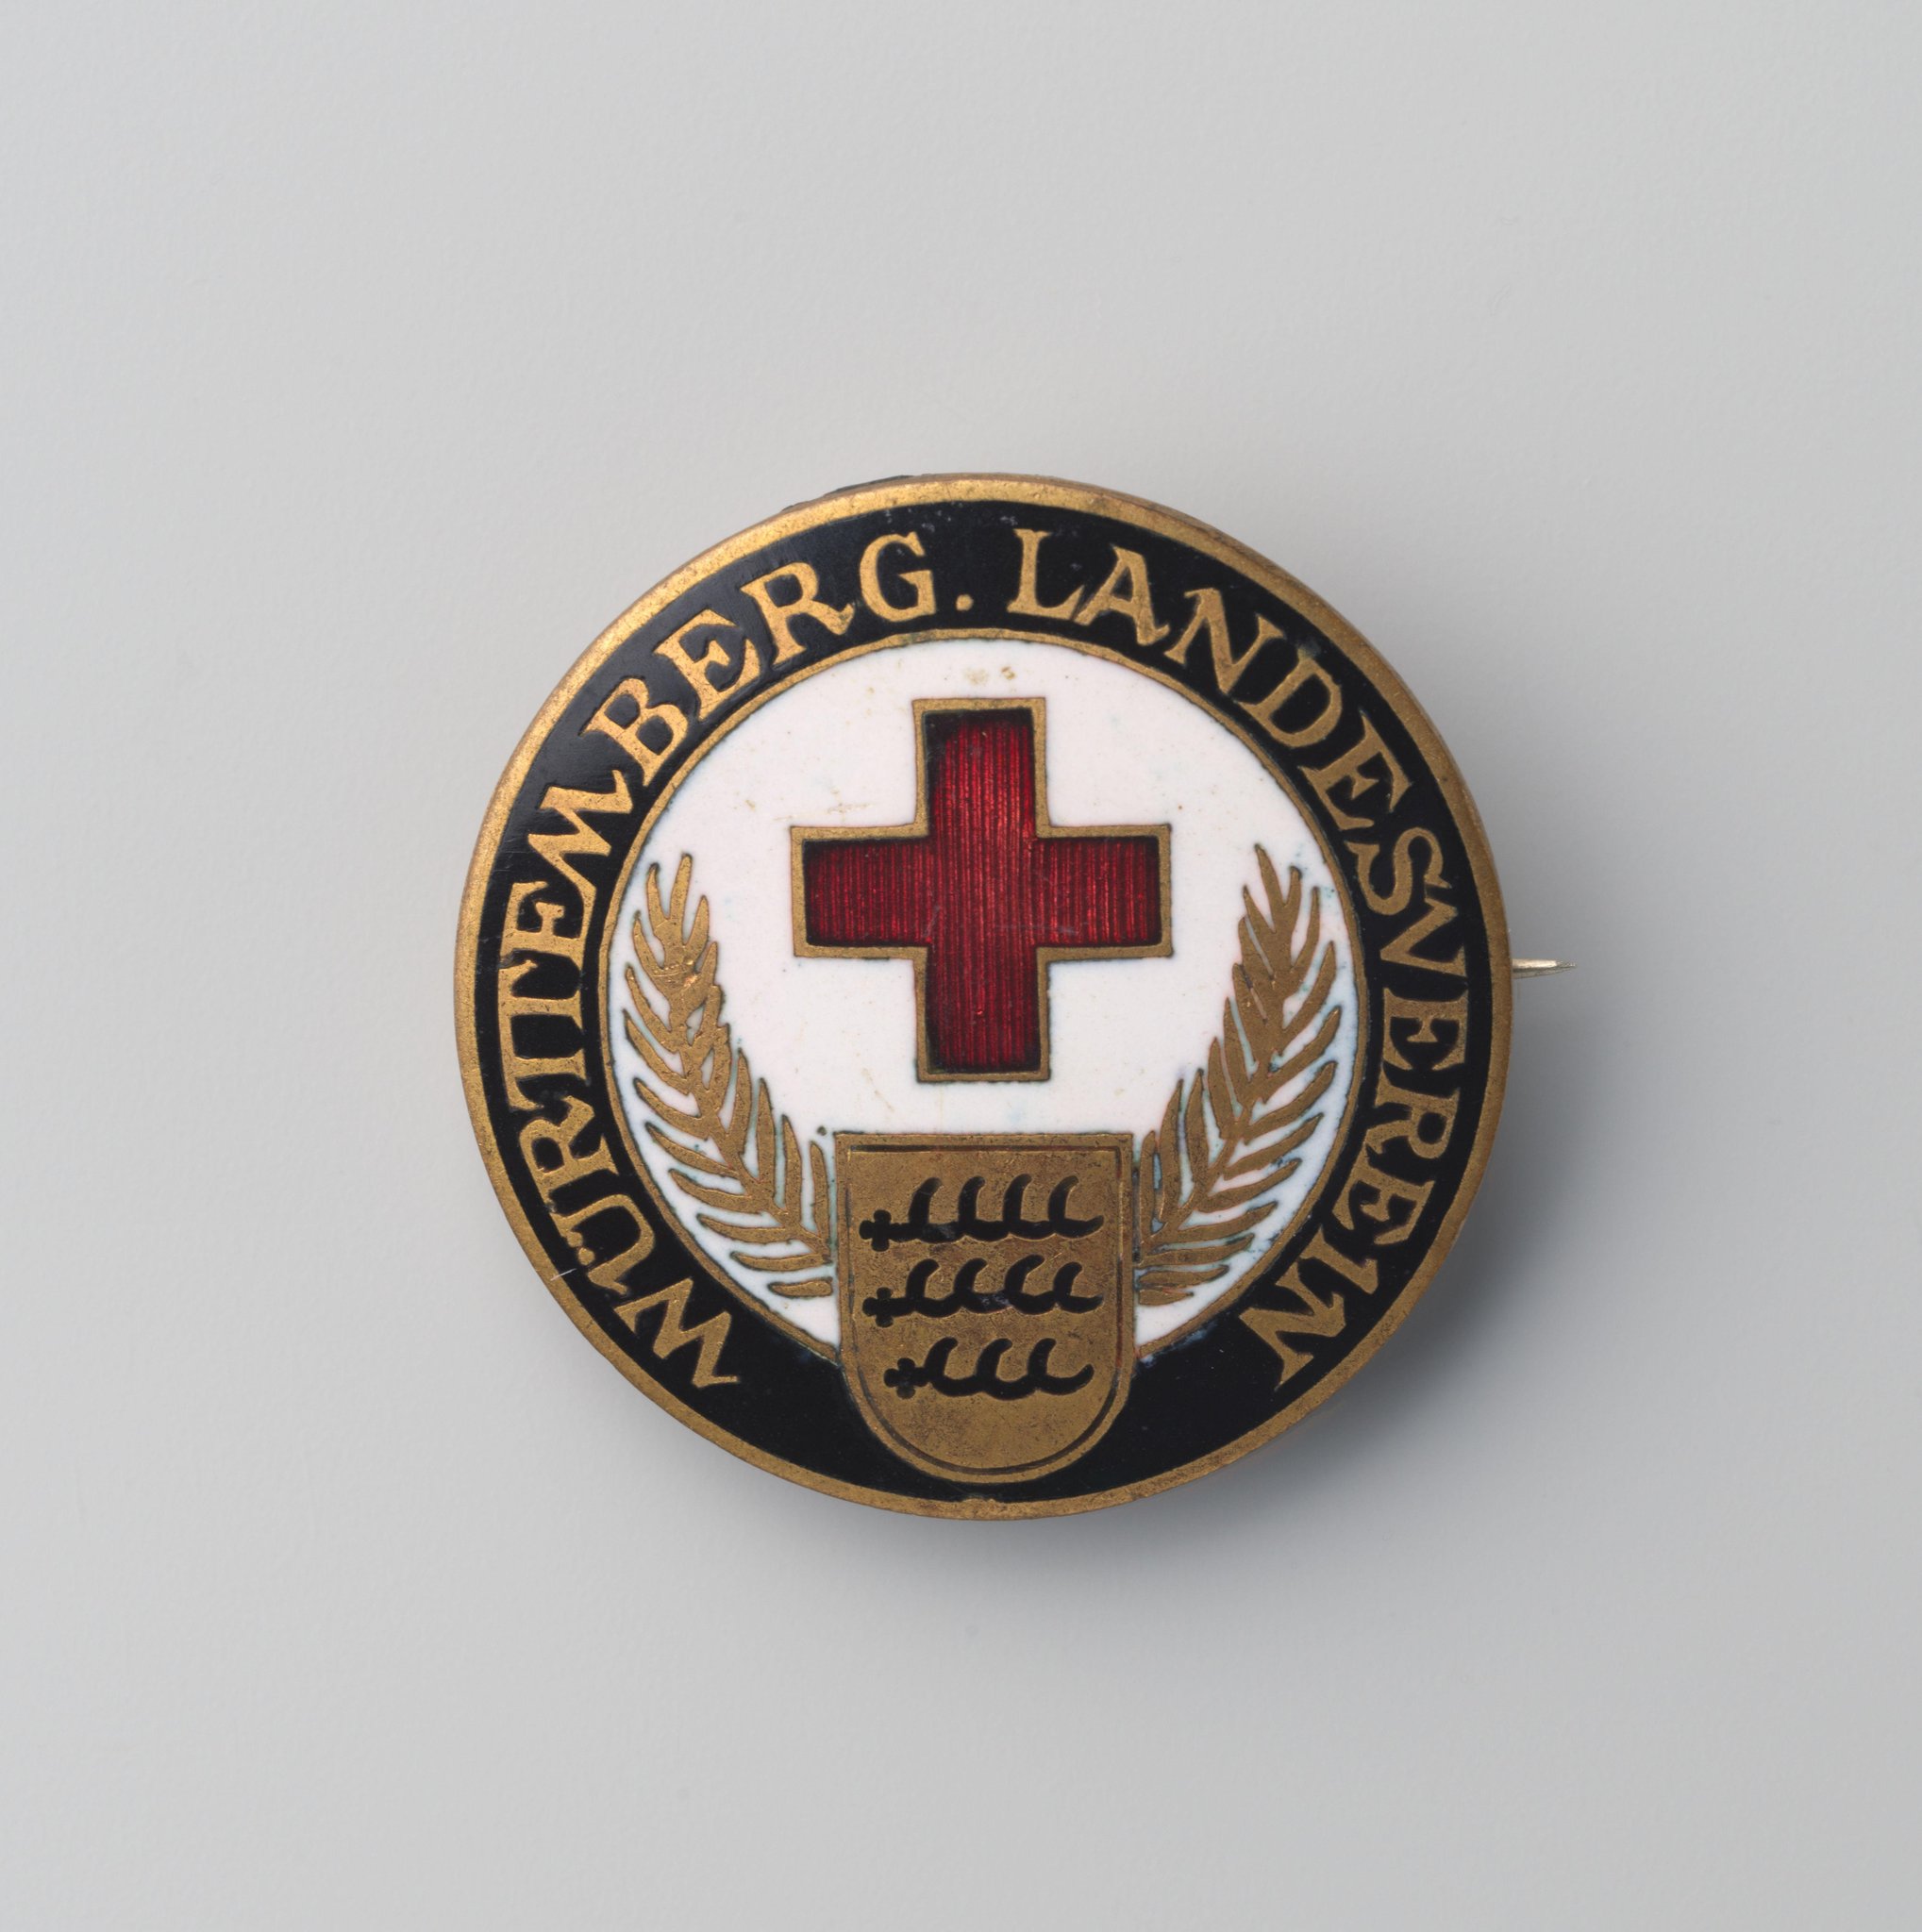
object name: onderscheidingsteken, onderscheiding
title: Onderscheiding (Stuttgart) voor verdienst tijdens de oorlog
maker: Anonymous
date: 1900-1925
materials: metal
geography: stuttgart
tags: eugen wachenheimer, else wachenheimer-moos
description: Dit object is onderdeel van de nalatenschap van Isabel Elon-Wachenheimer (1928-2010). Tot haar overlijden behoorde het samen met de andere objecten uit de nalatenschap tot haar privédomein van Isabel Wachenheimer. In die particuliere context zijn deze objecten tezamen en individueel aandenkens - aan de jeugd, ouders en familie van Isabel Wachenheimer vóór en tijdens de Shoah en aan haar leven na de Tweede Wereldoorlog. Isabel Wachenheimer, die van juni 1943 tot mei 1945 gevangen zat in Kamp Westerbork, Theresienstadt, Auschwitz, Lenzing a/d Oberdonau (een buitenkamp van Mauthausen), overleefde de Shoah. Haar ouders – Eugène Wachenheimer en Else Wachenheimer-Moos - werden op 14 oktober 1944 in Auschwitz-Birkenau vermoord.